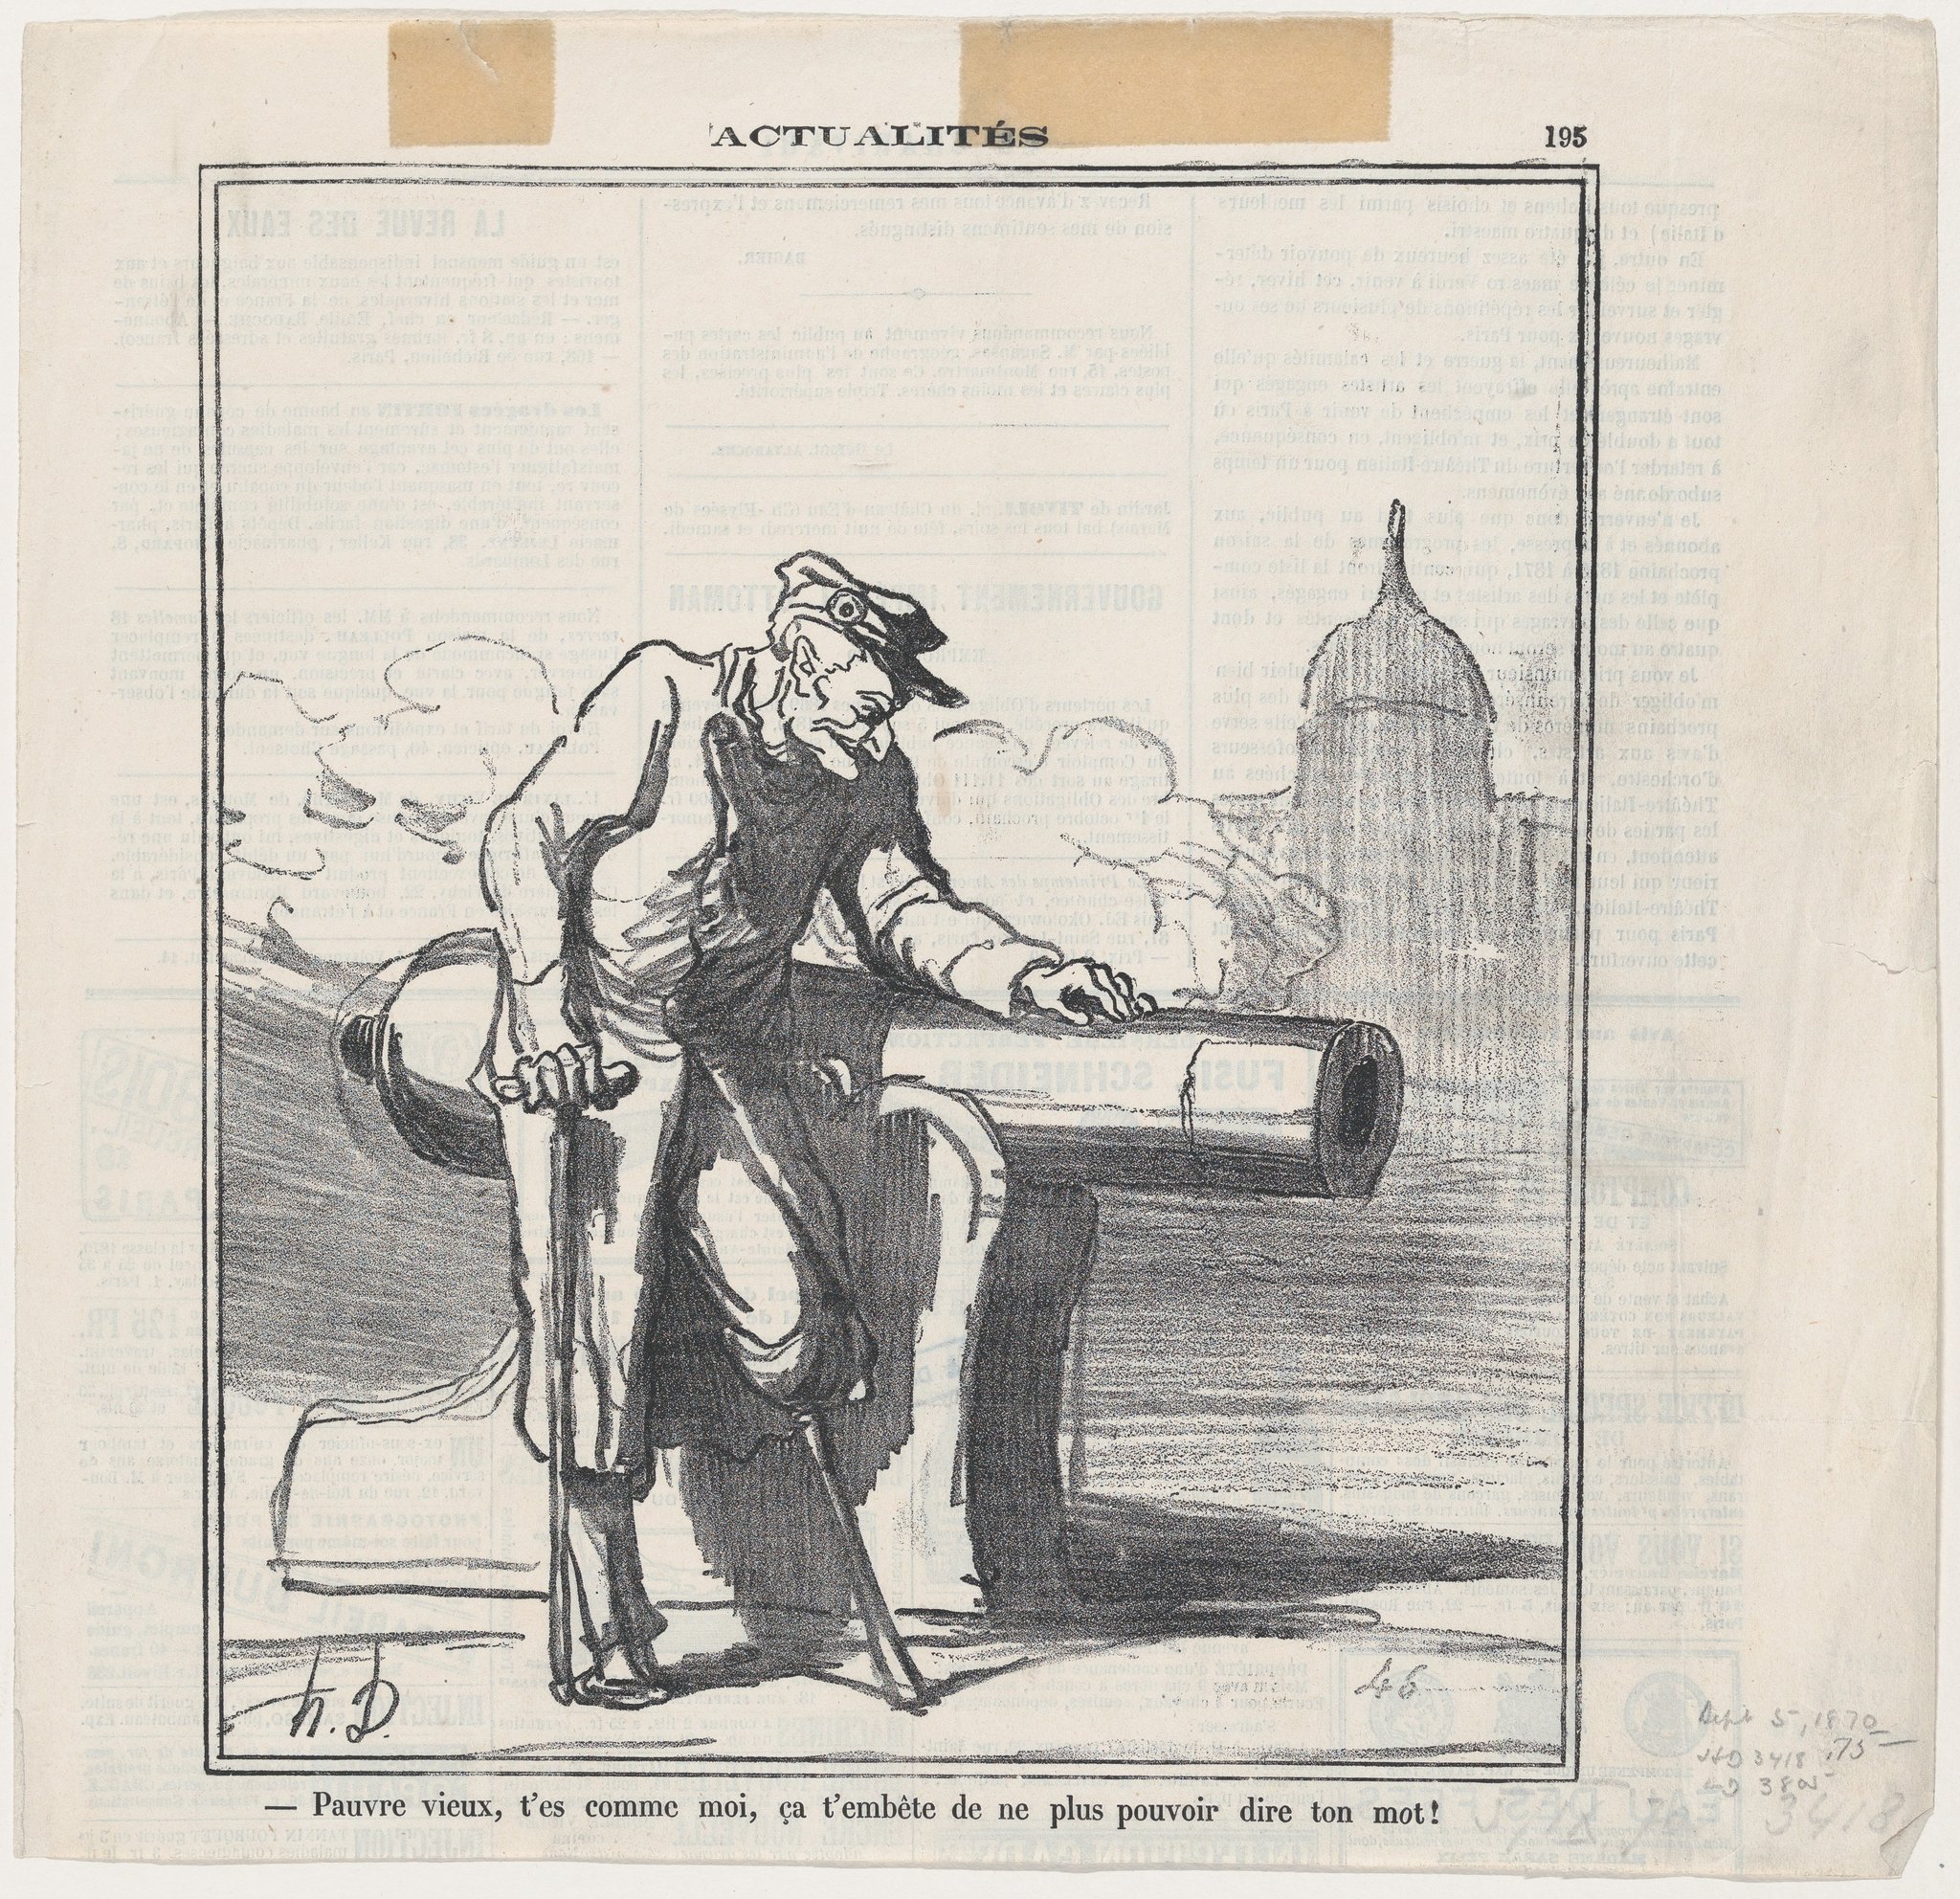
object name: print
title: Poor old fellow. You are like me... it annoys you that you cannot speak up as you would like to, from 'News of the day,' published in "Le Charivari"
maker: honoré daumier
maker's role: artist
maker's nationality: french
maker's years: 1808-1879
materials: paper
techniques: lithograph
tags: satire,cannons,men